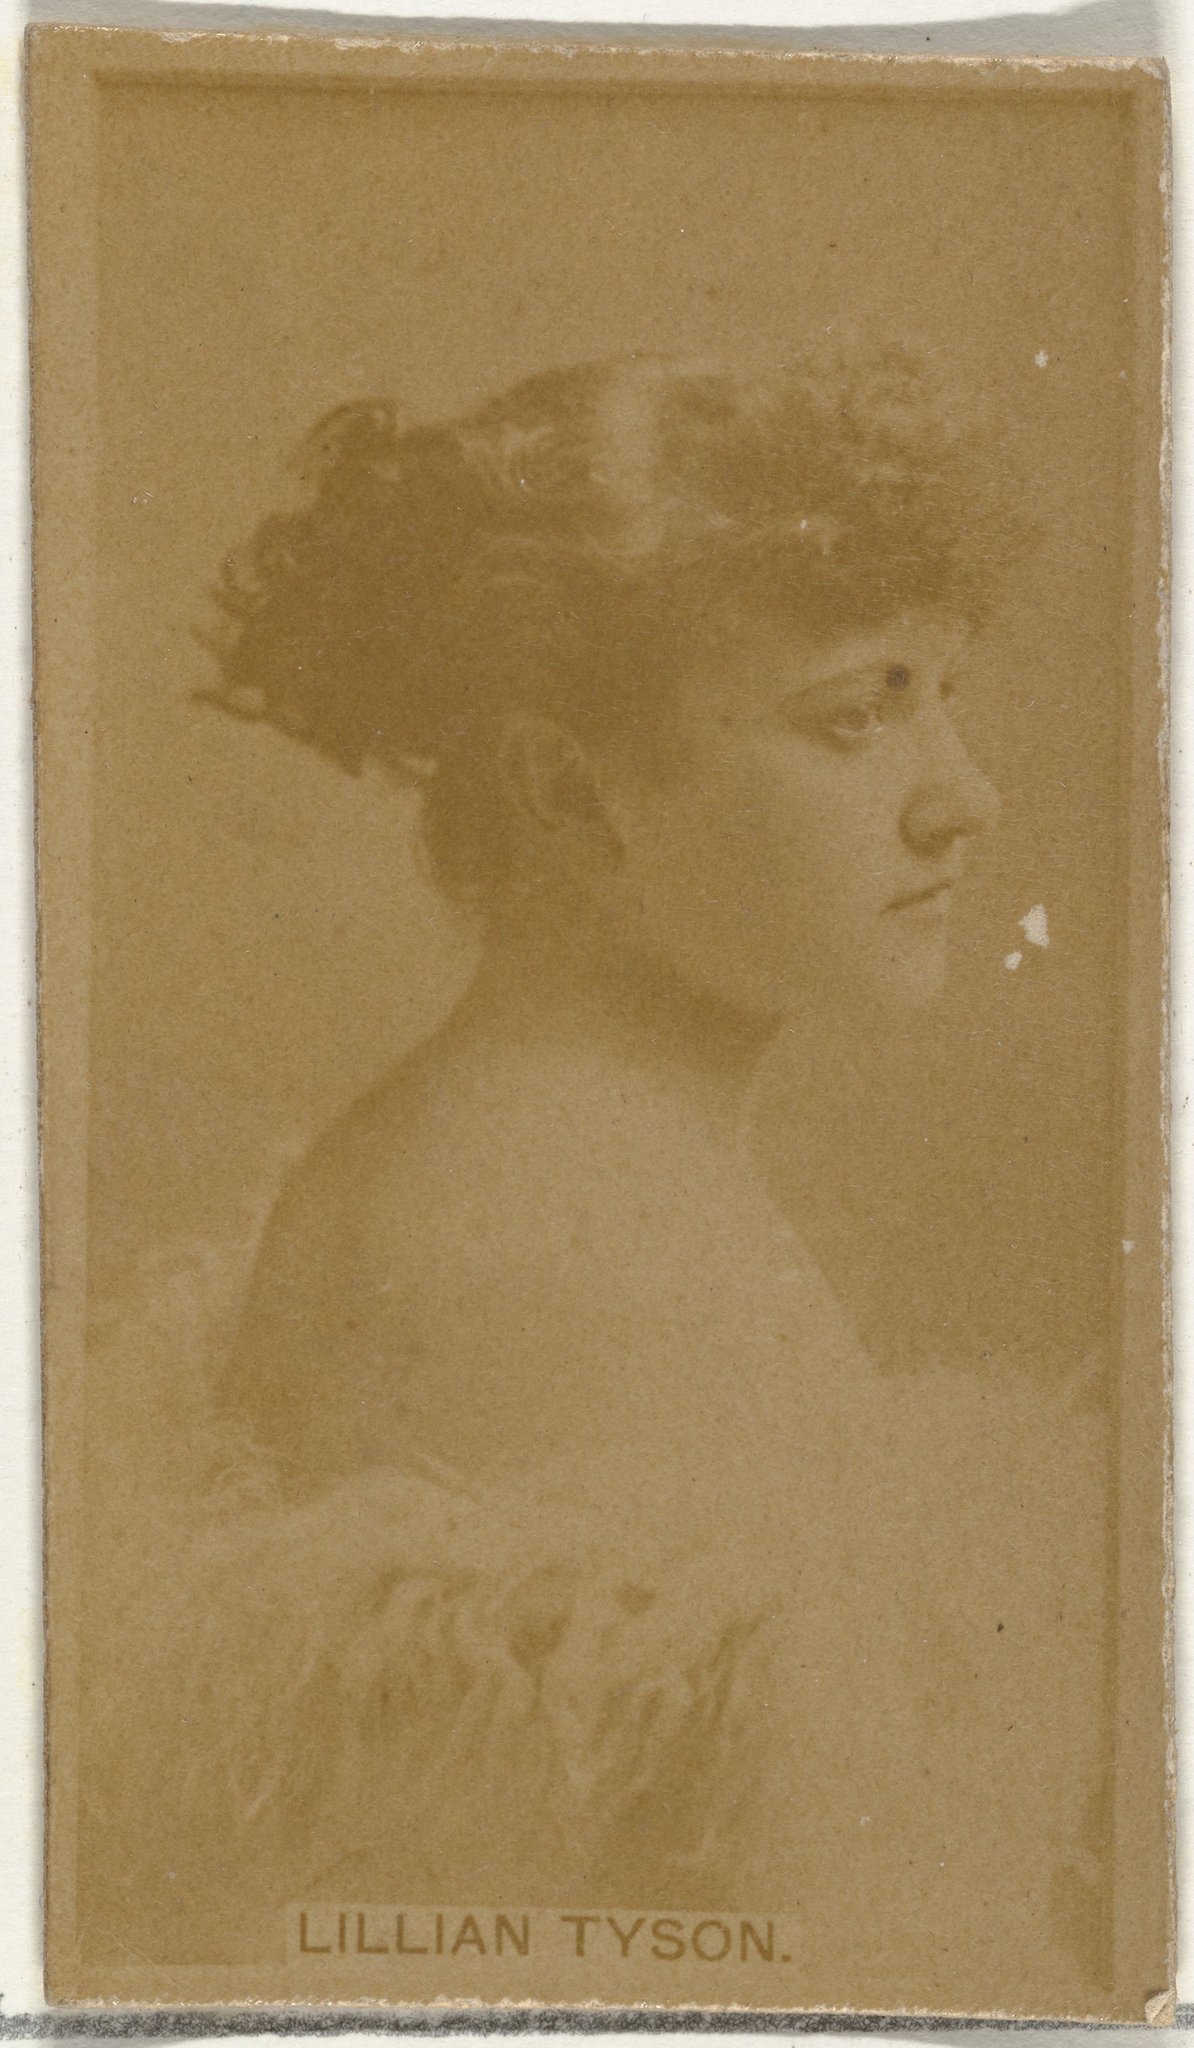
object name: photograph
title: Lillian Tyson, from the Actors and Actresses series (N145-8) issued by Duke Sons & Co. to promote Duke Cigarettes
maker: w. duke, sons & co.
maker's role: publisher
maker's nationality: american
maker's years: 1870-1920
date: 1891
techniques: albumen silver print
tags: portraits,women,actresses